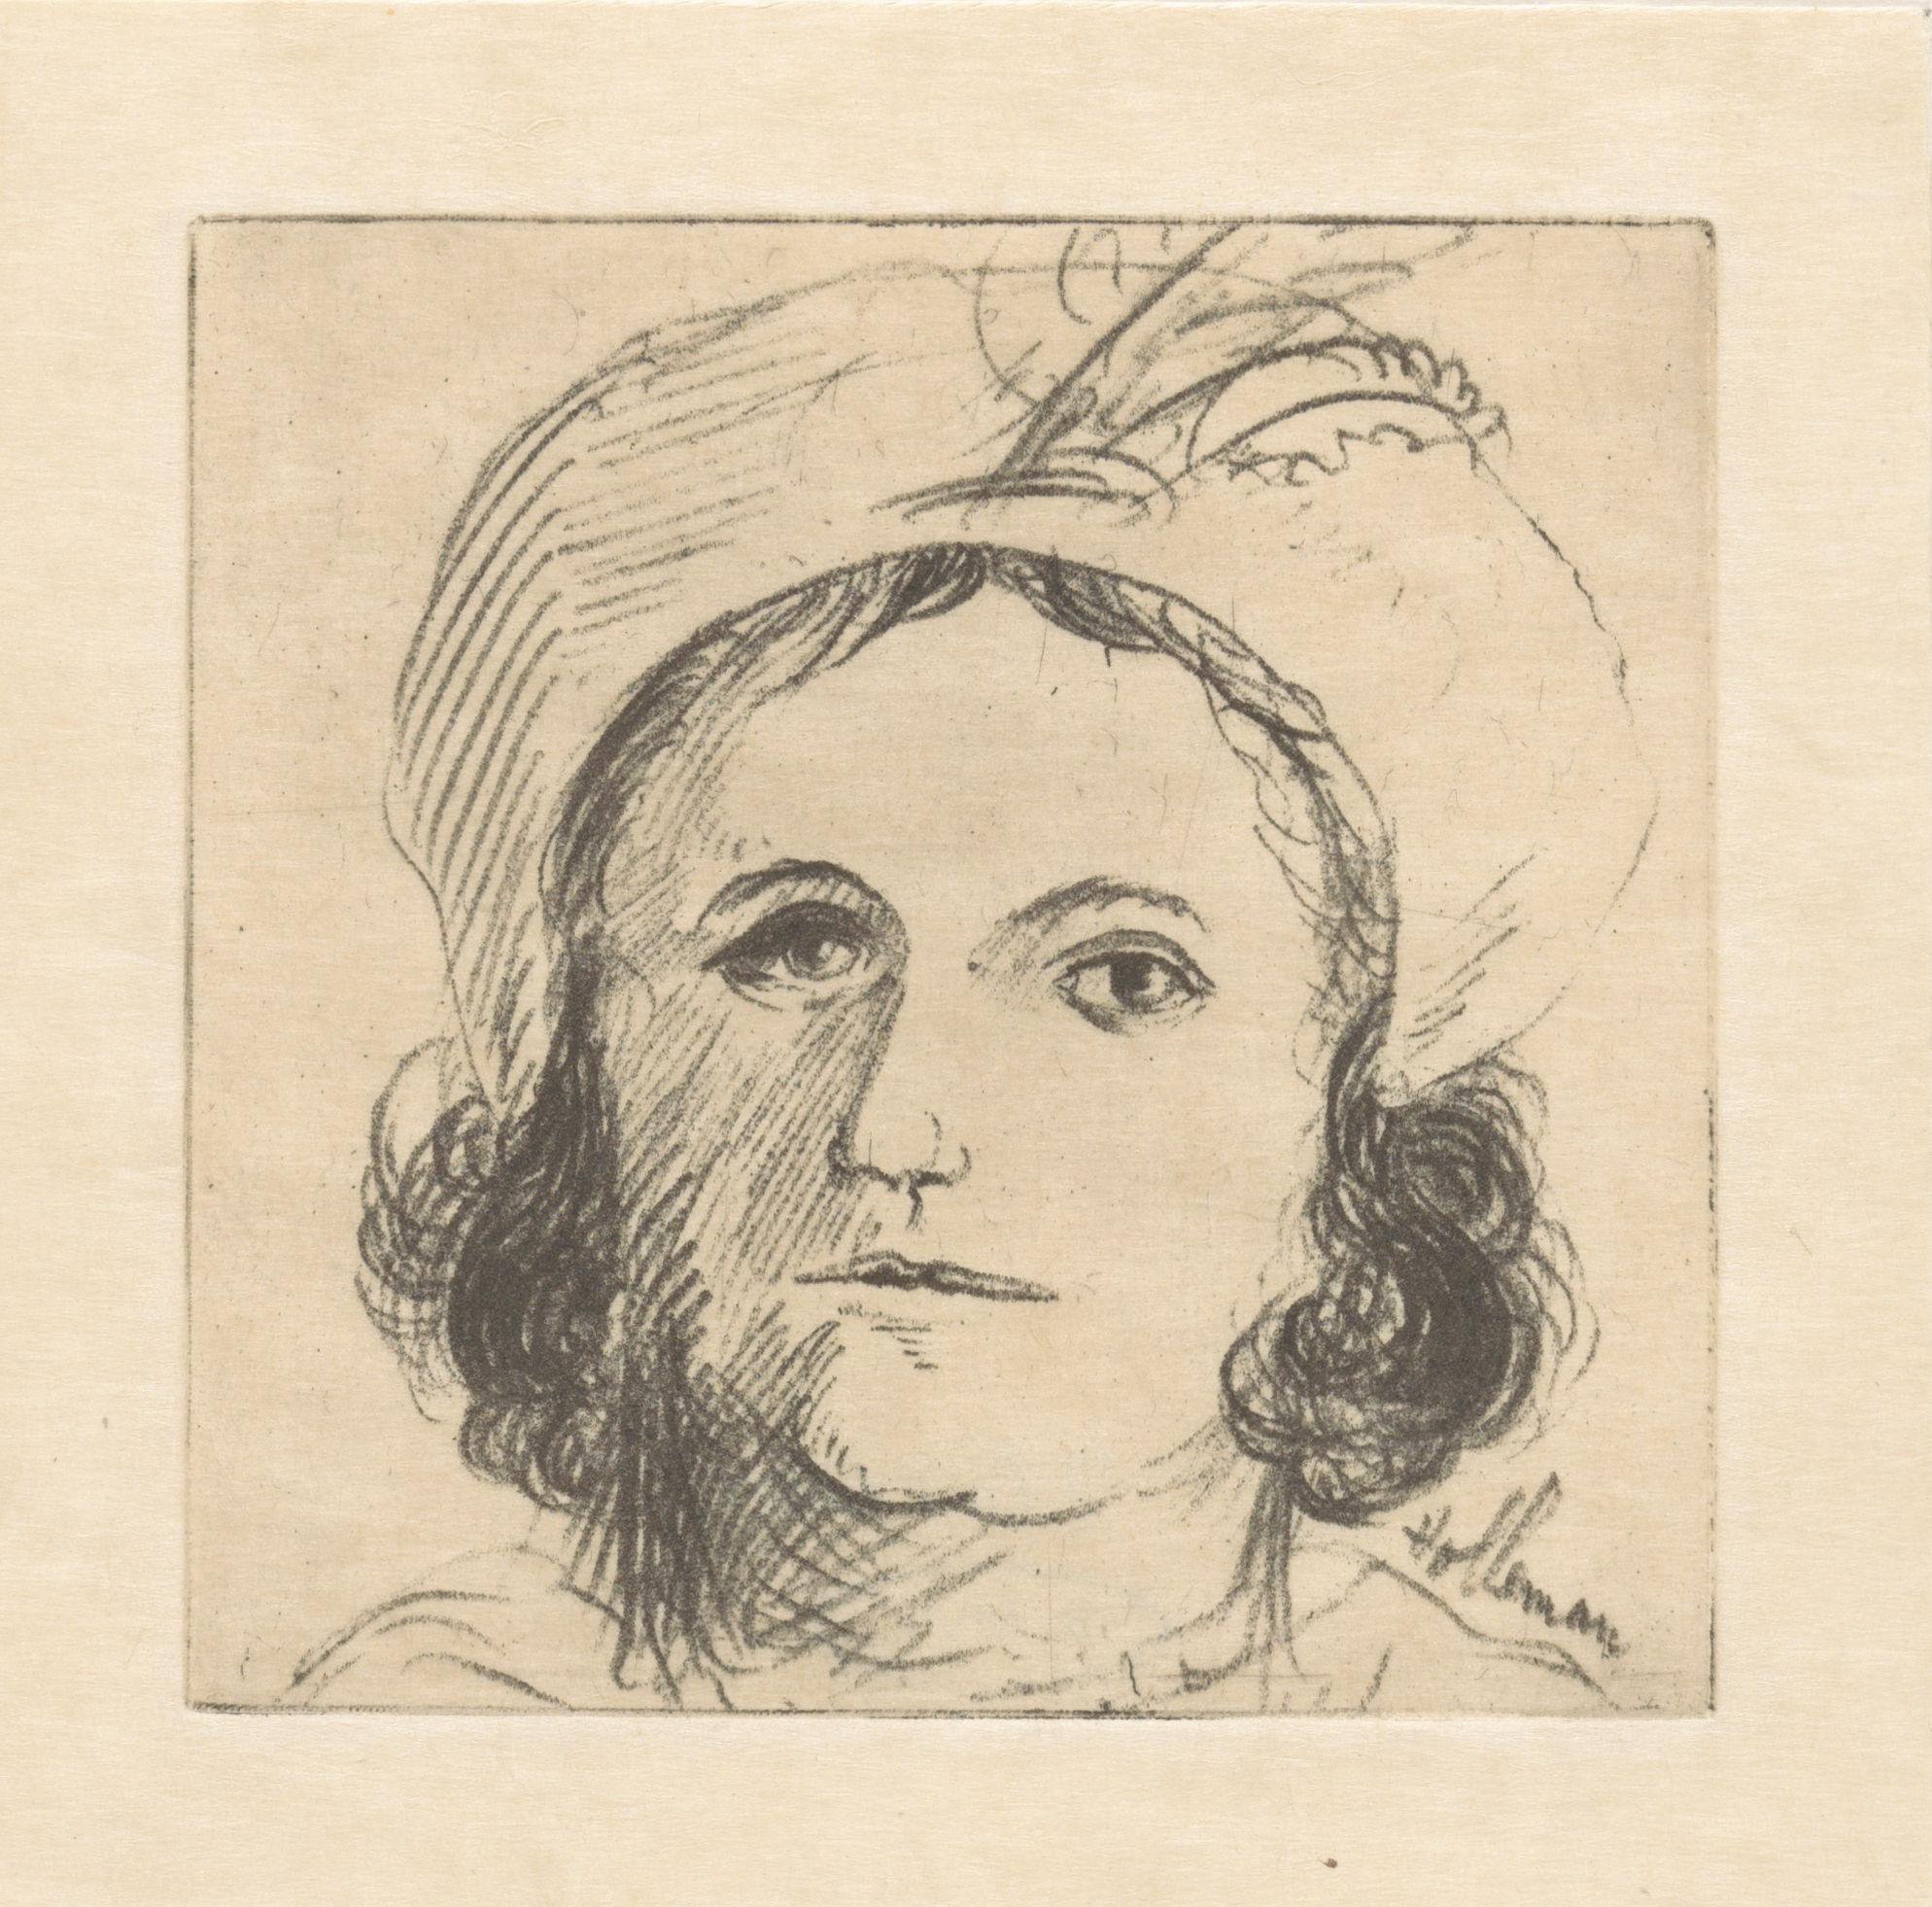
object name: print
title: Vrouw met hoed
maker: marius holleman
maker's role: draughtsman, print maker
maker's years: 1878-1926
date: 1904-1926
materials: paper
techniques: etching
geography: groningen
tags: head-gear: hat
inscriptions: collector's mark: Lugt 2228